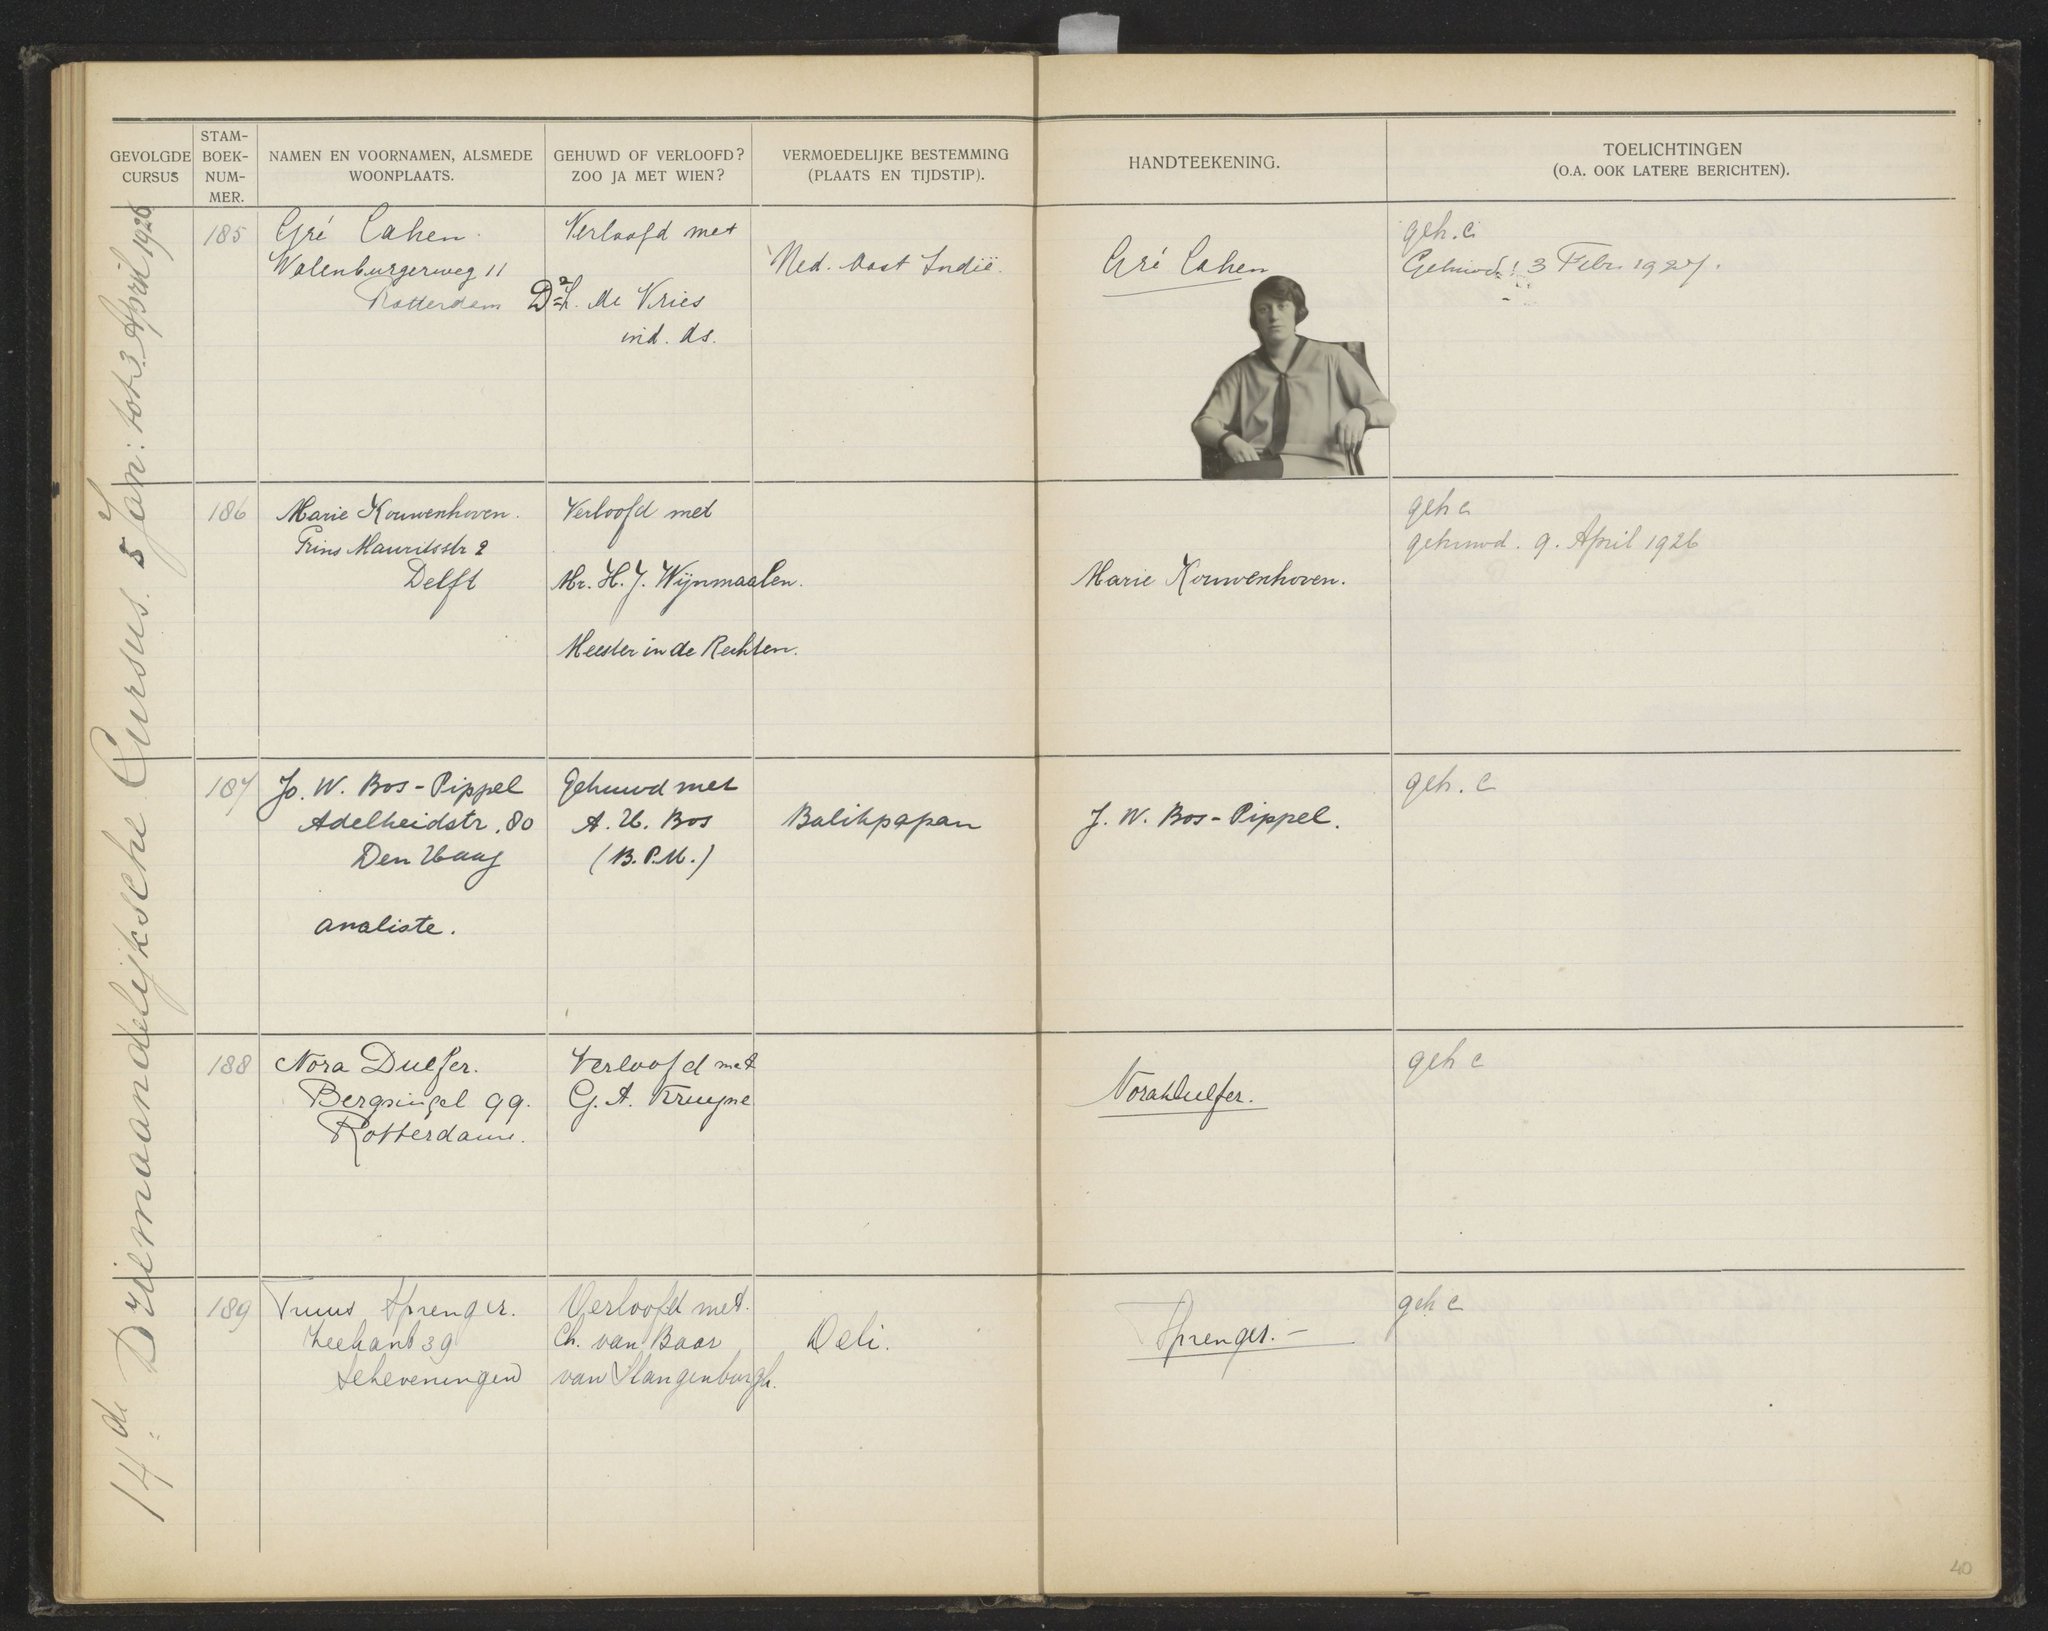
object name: album leaf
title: Blad 40 uit Stamboek van de leerlingen der Koloniale School voor Meisjes en Vrouwen te 's-Gravenhage deel I (1921-1929)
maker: Anonymous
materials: paper, photographic support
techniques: photography, printing, writing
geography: the hague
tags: further education (+ pupil), further education, the hague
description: Twee pagina's met gegevens van de deelnemers aan de 14e driemaandelijkse cursus van 5 januari tot en met 3 april 1926, stamboeknummers 185 tot en met 189. Onderdeel van Stamboek van de leerlingen der Koloniale School voor Meisjes en Vrouwen te 's-Gravenhage deel I (1921-1929).